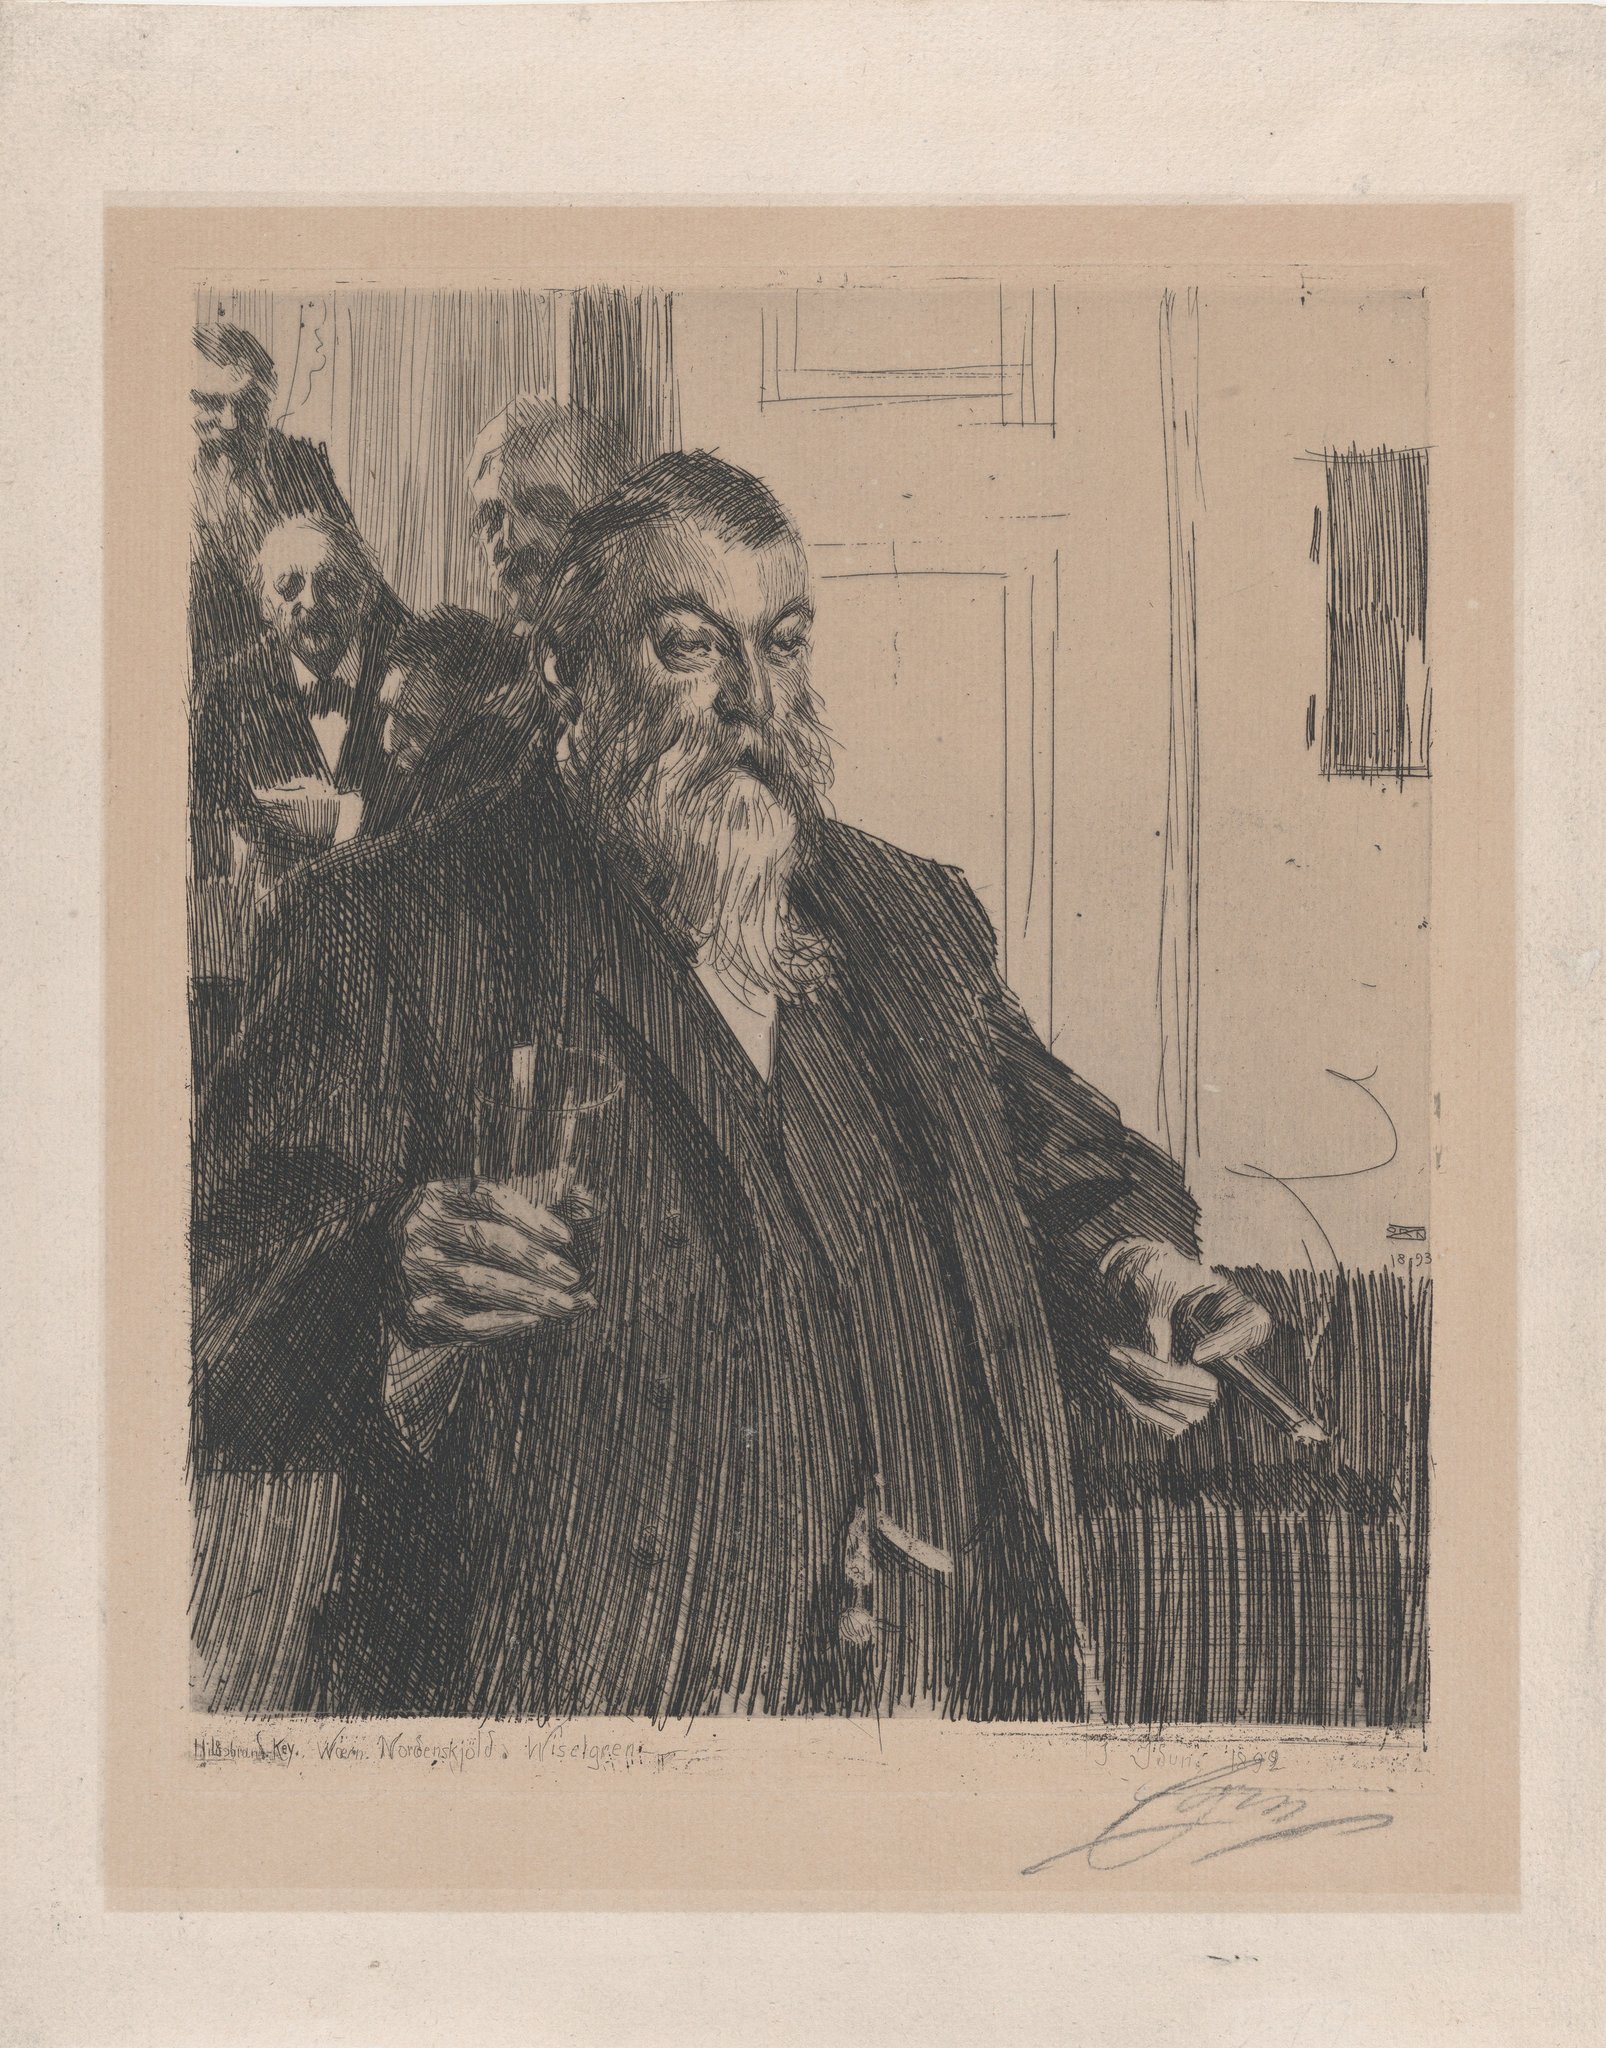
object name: print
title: A Toast II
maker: anders zorn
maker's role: artist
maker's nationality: swedish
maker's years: 1860-1920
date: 1893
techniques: etching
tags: men,smoking,drinking